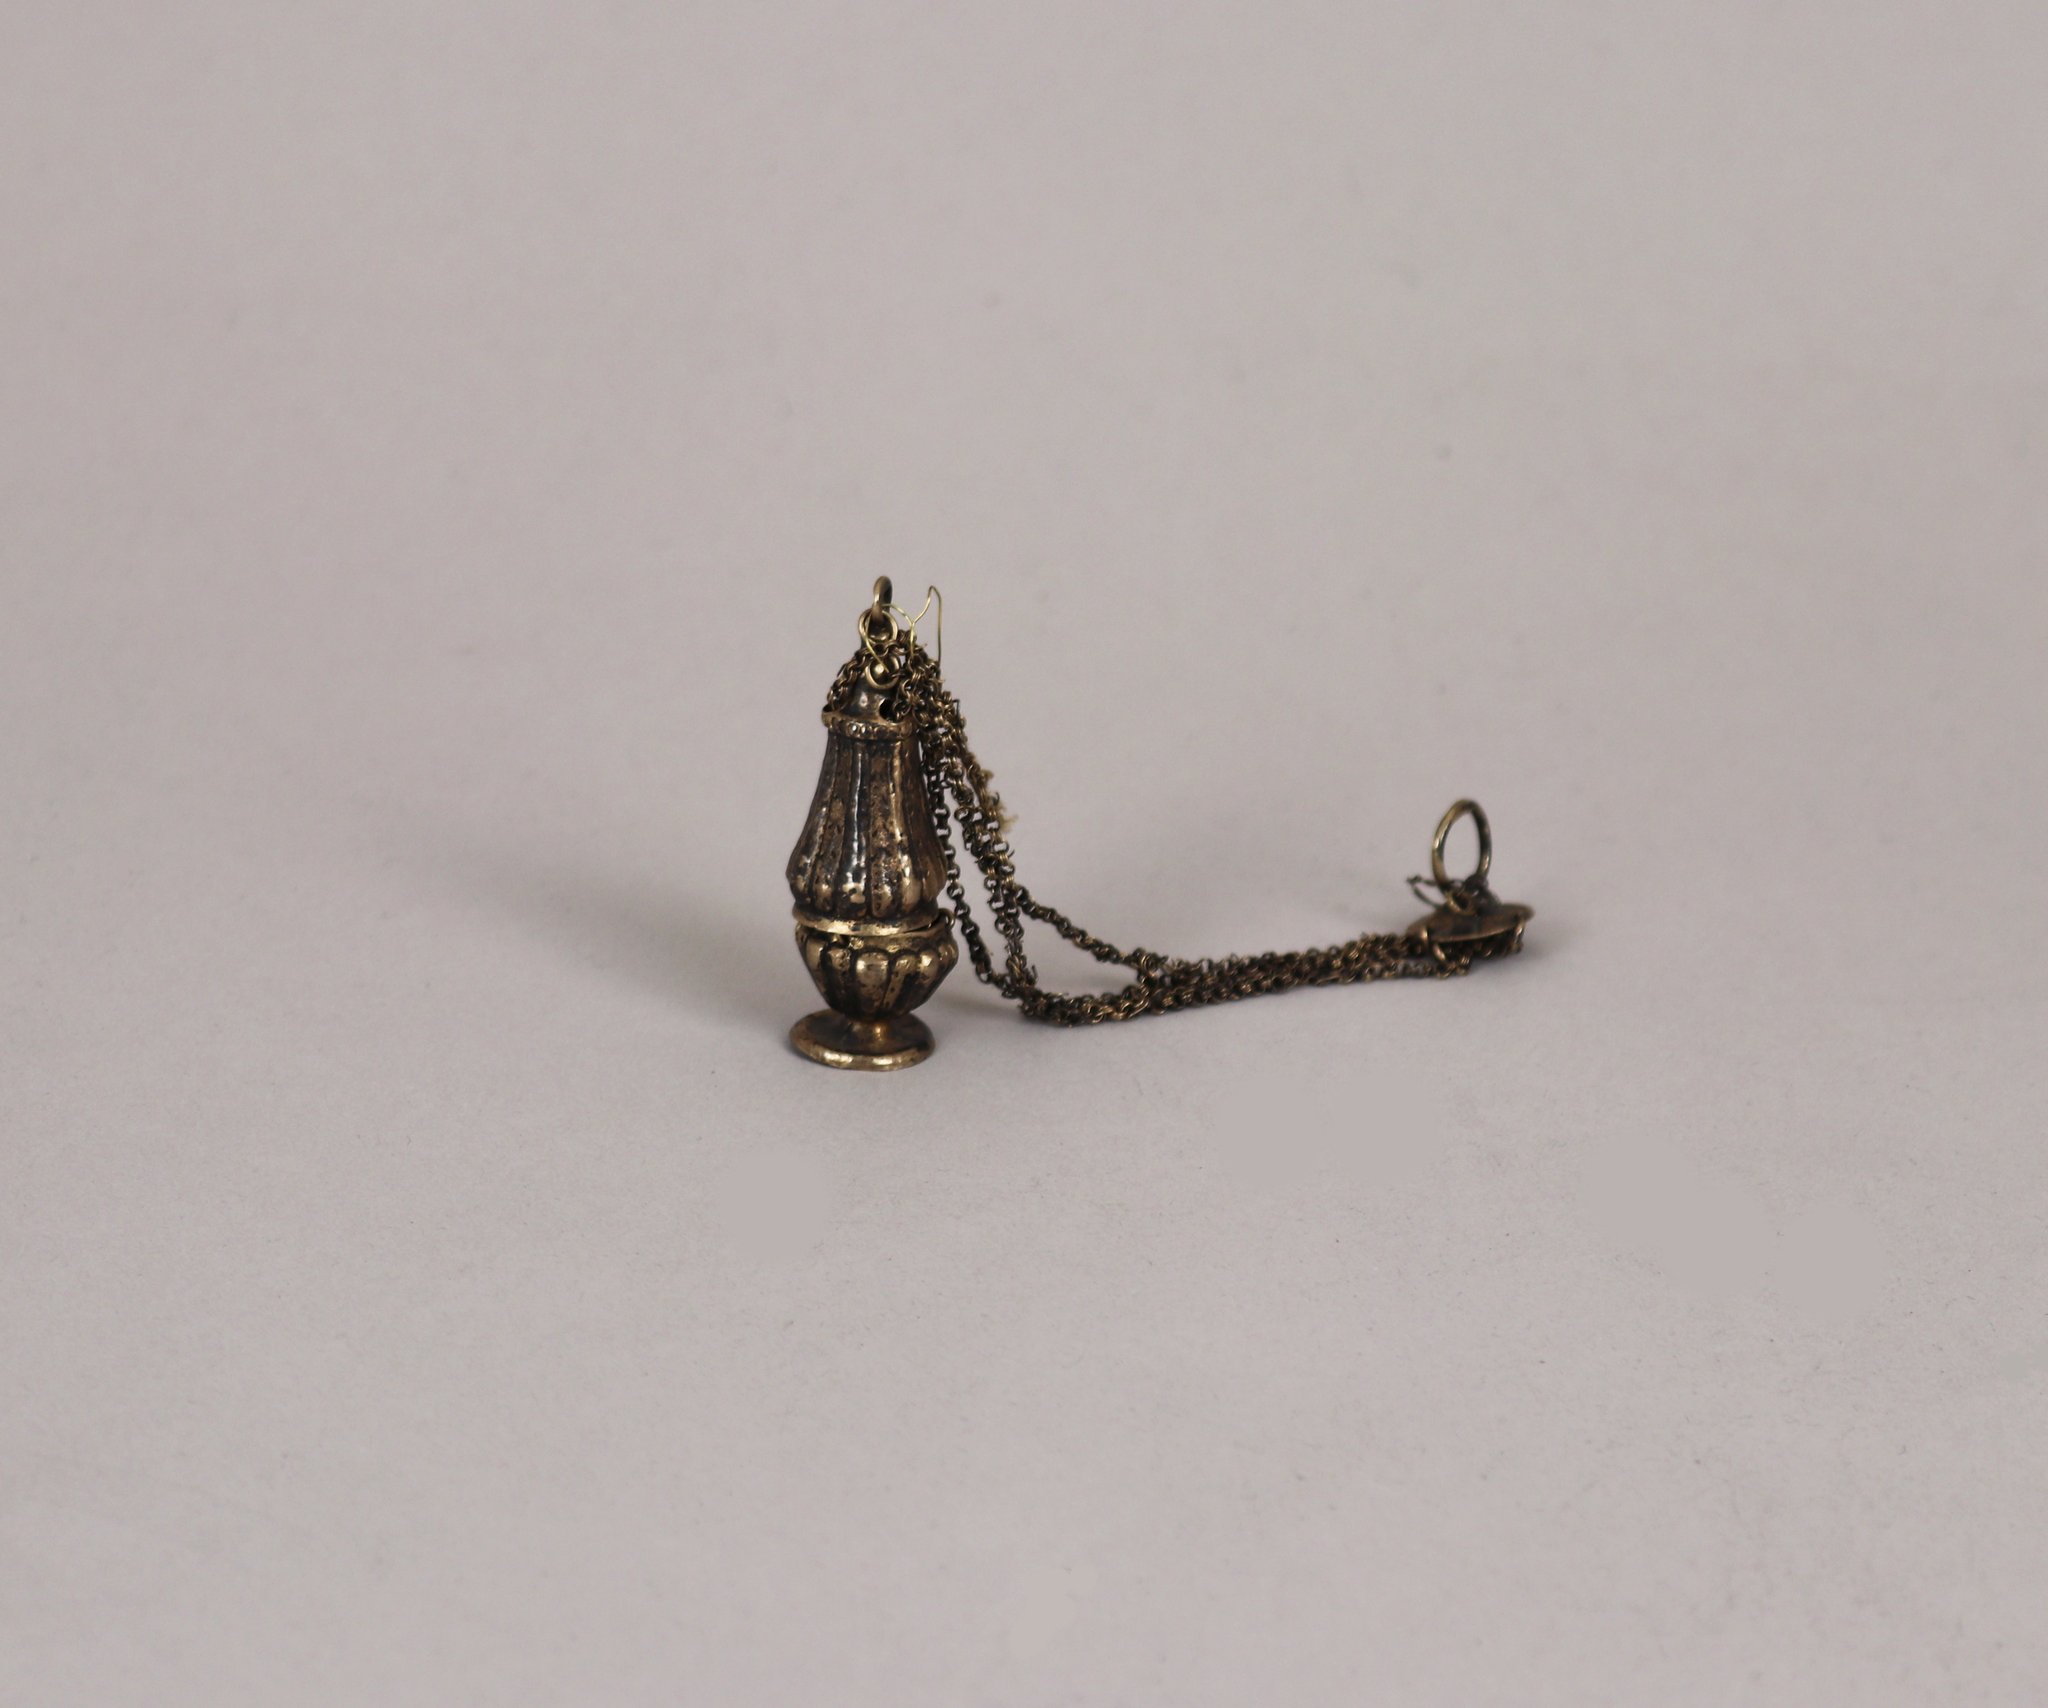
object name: crèche figure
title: Censer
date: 1751-1800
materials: silver gilt